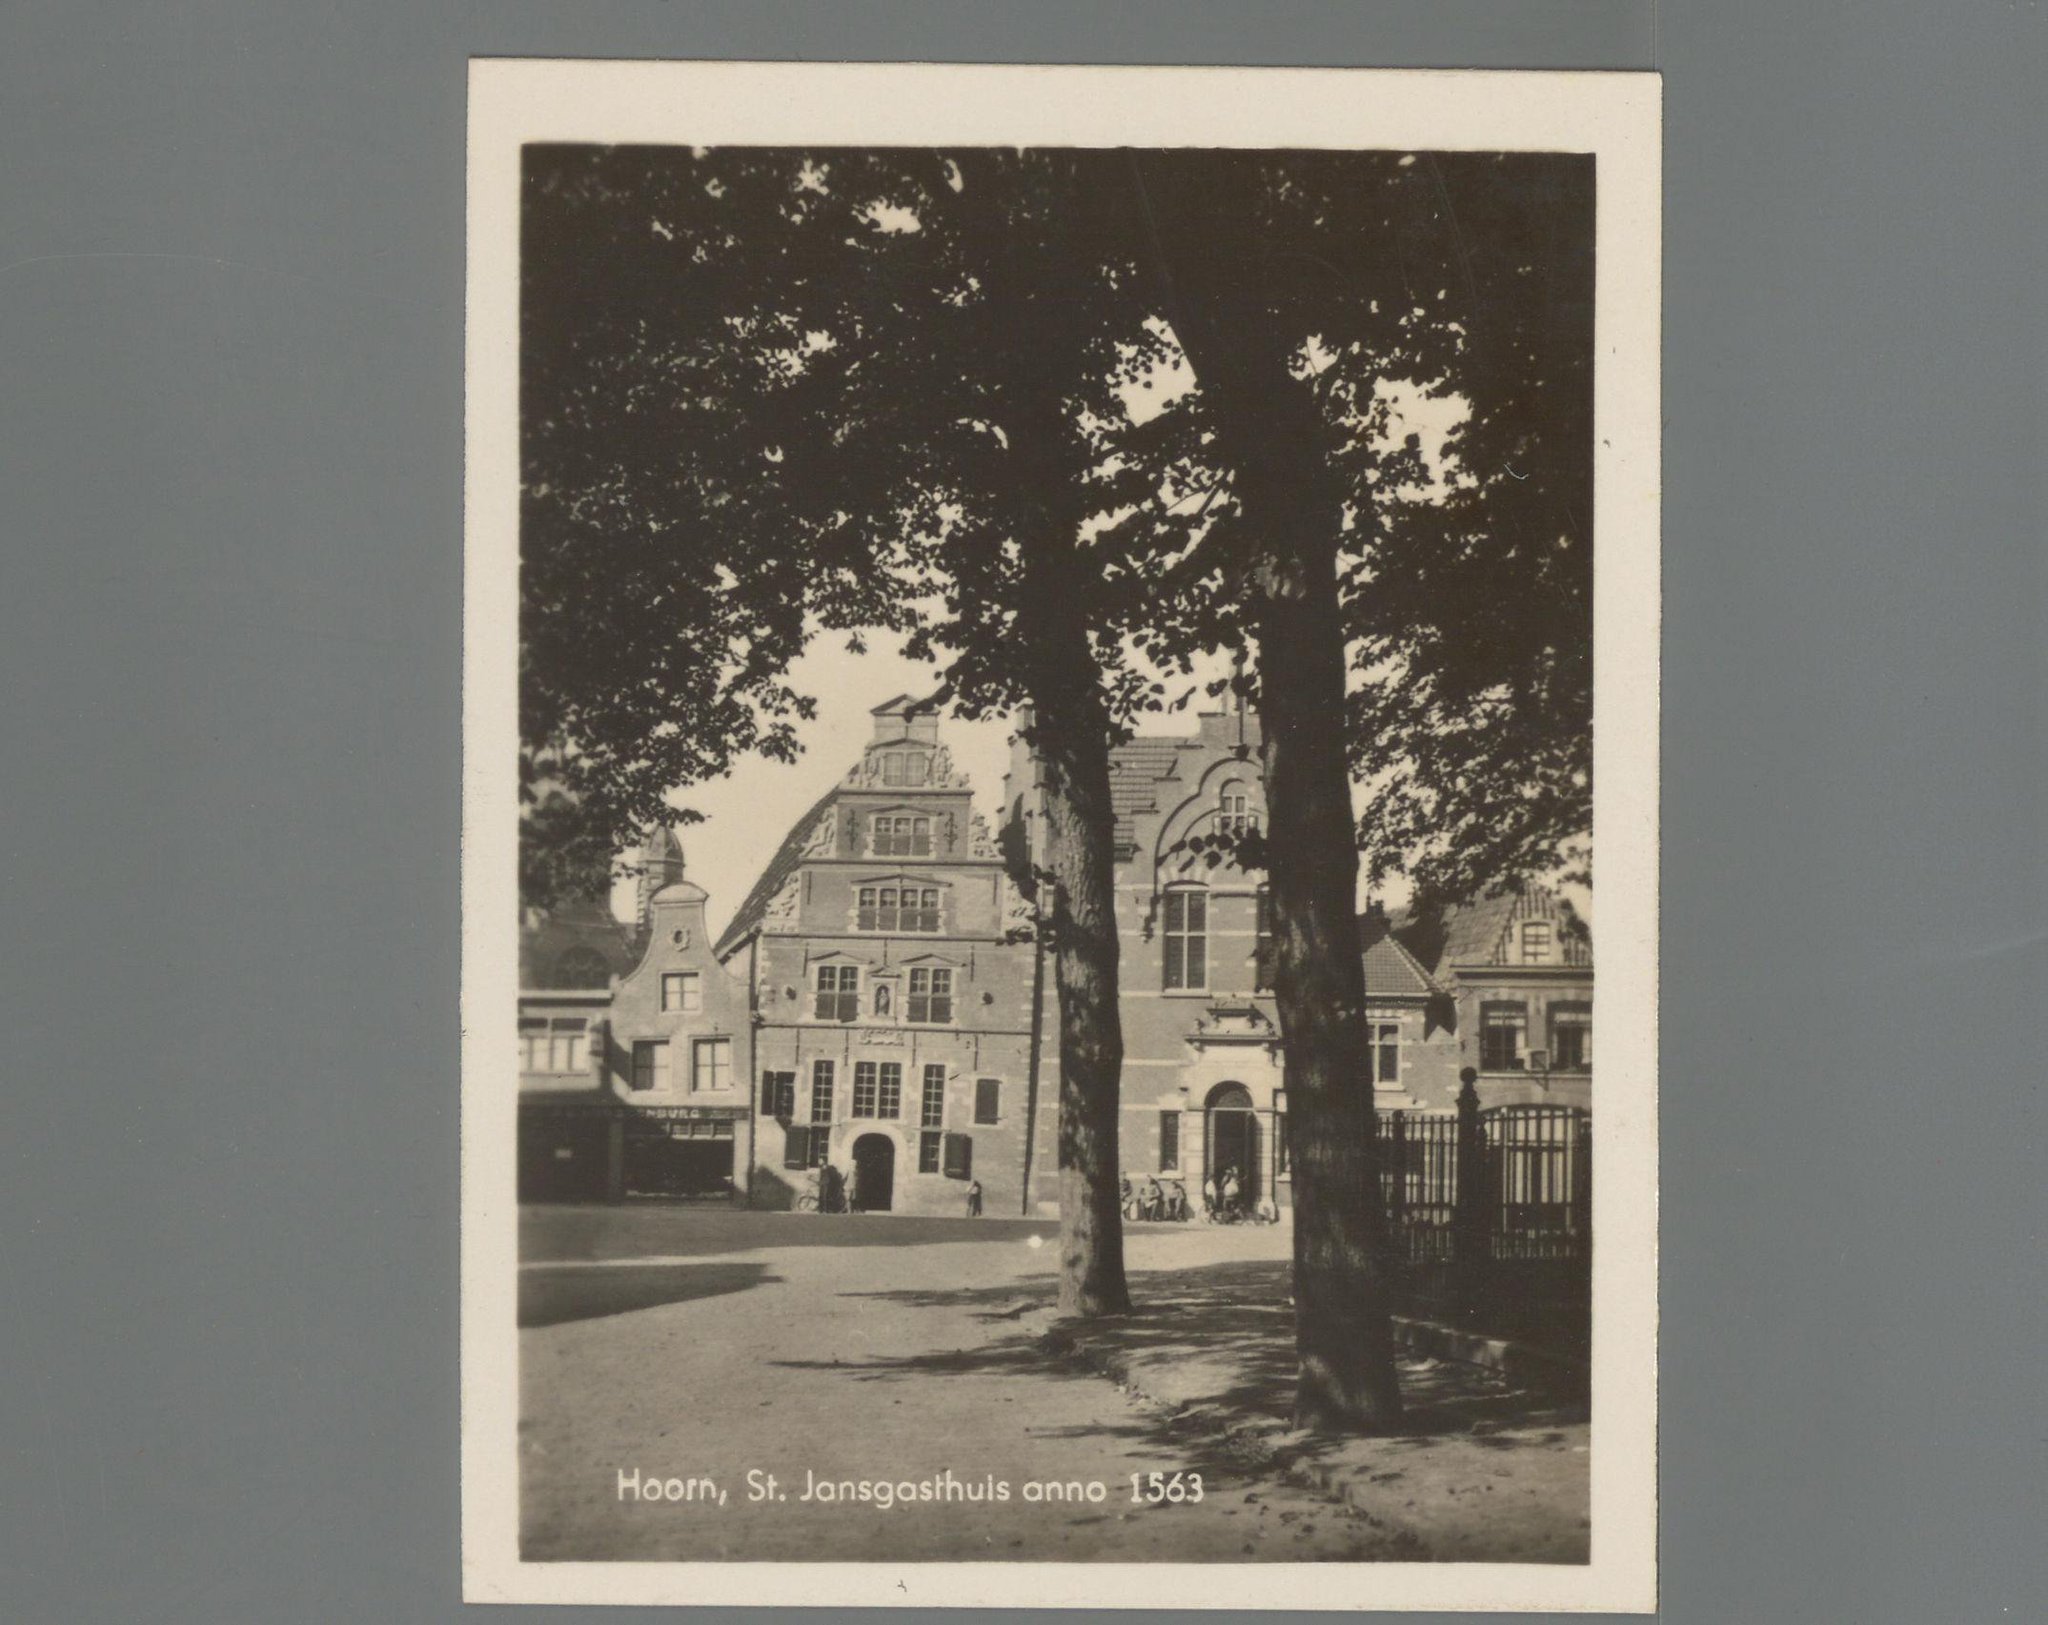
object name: photograph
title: Hoorn, St. Jansgasthuis anno 1563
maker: Anonymous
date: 1900-1950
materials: paper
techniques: gelatin silver print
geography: hoorn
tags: hospital